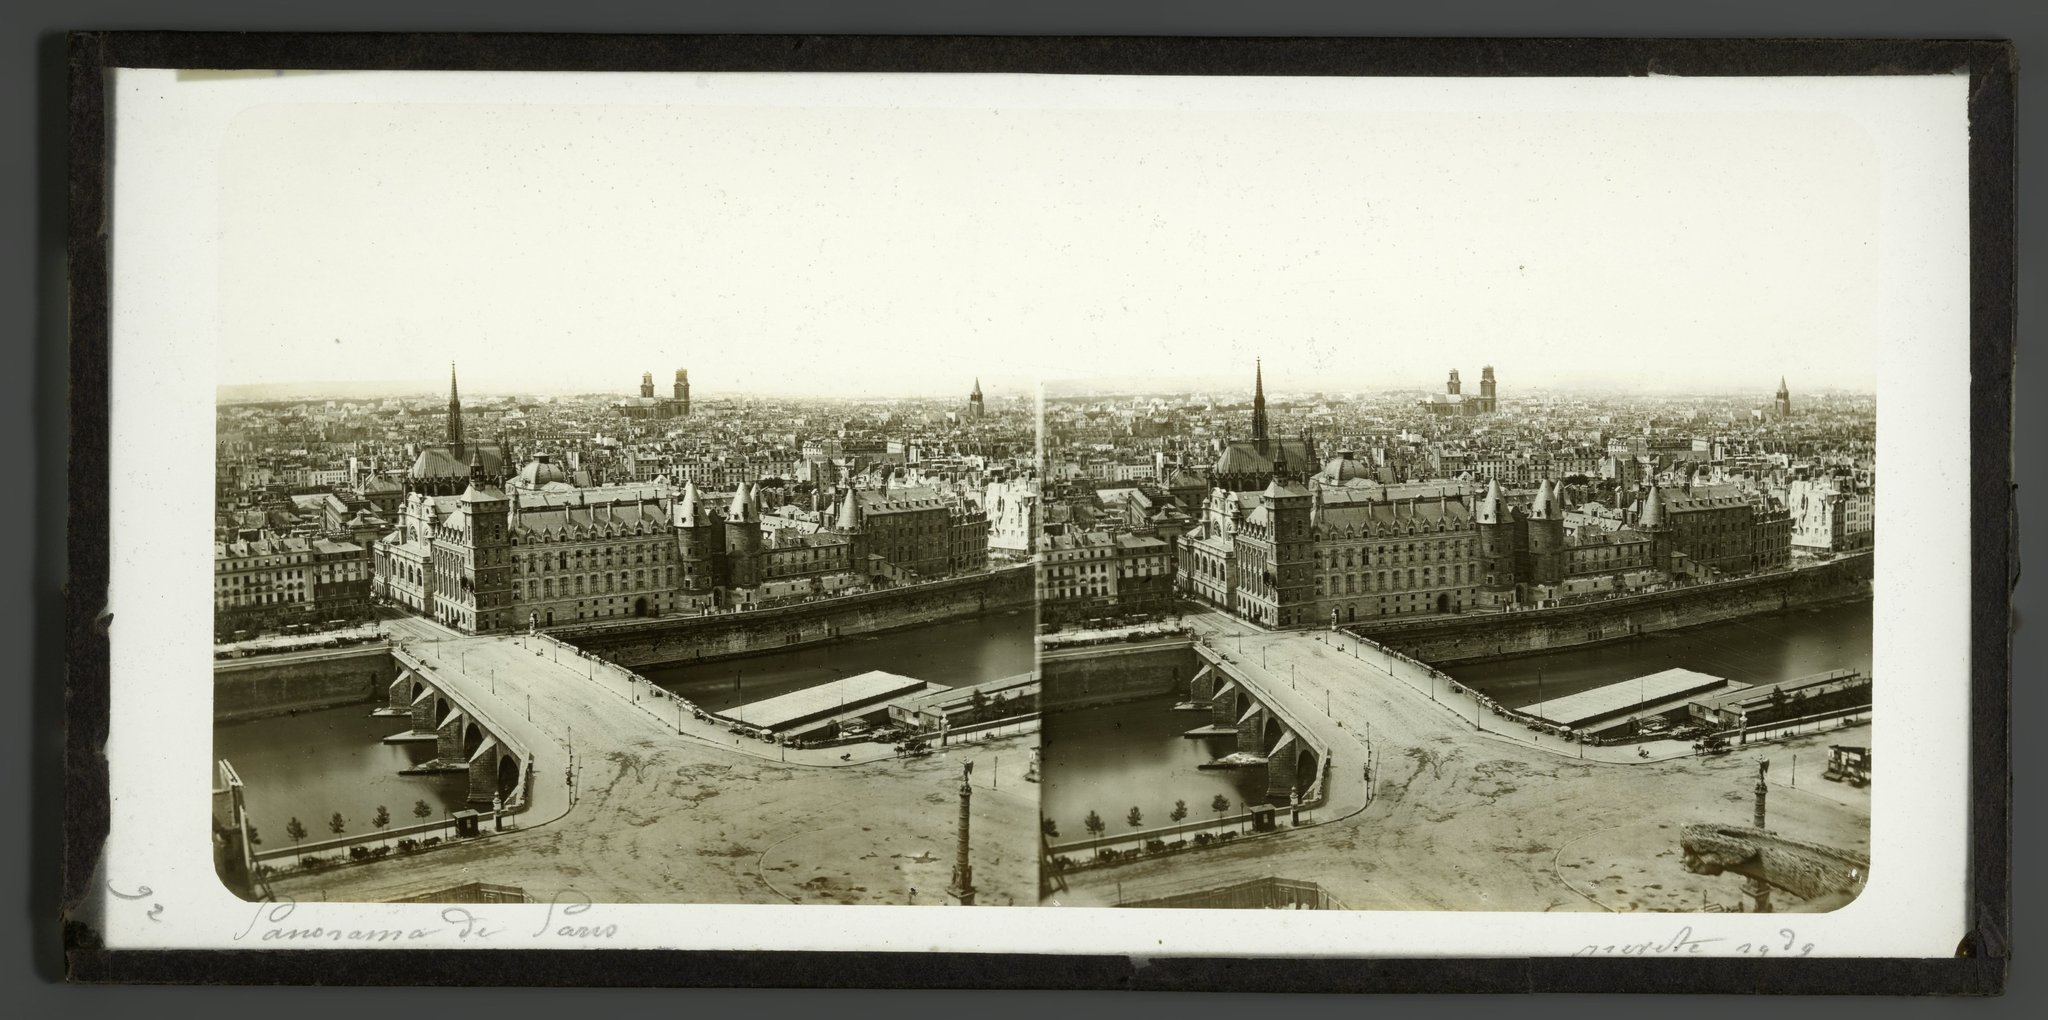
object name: stereoscopic photograph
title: Gezicht op Parijs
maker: Anonymous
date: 1856-1890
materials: glass, paper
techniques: slide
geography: paris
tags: city-view in general; 'veduta', paris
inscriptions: annotation: ‘92 Panorama de Paris/ Breveté s.g.d.g.’